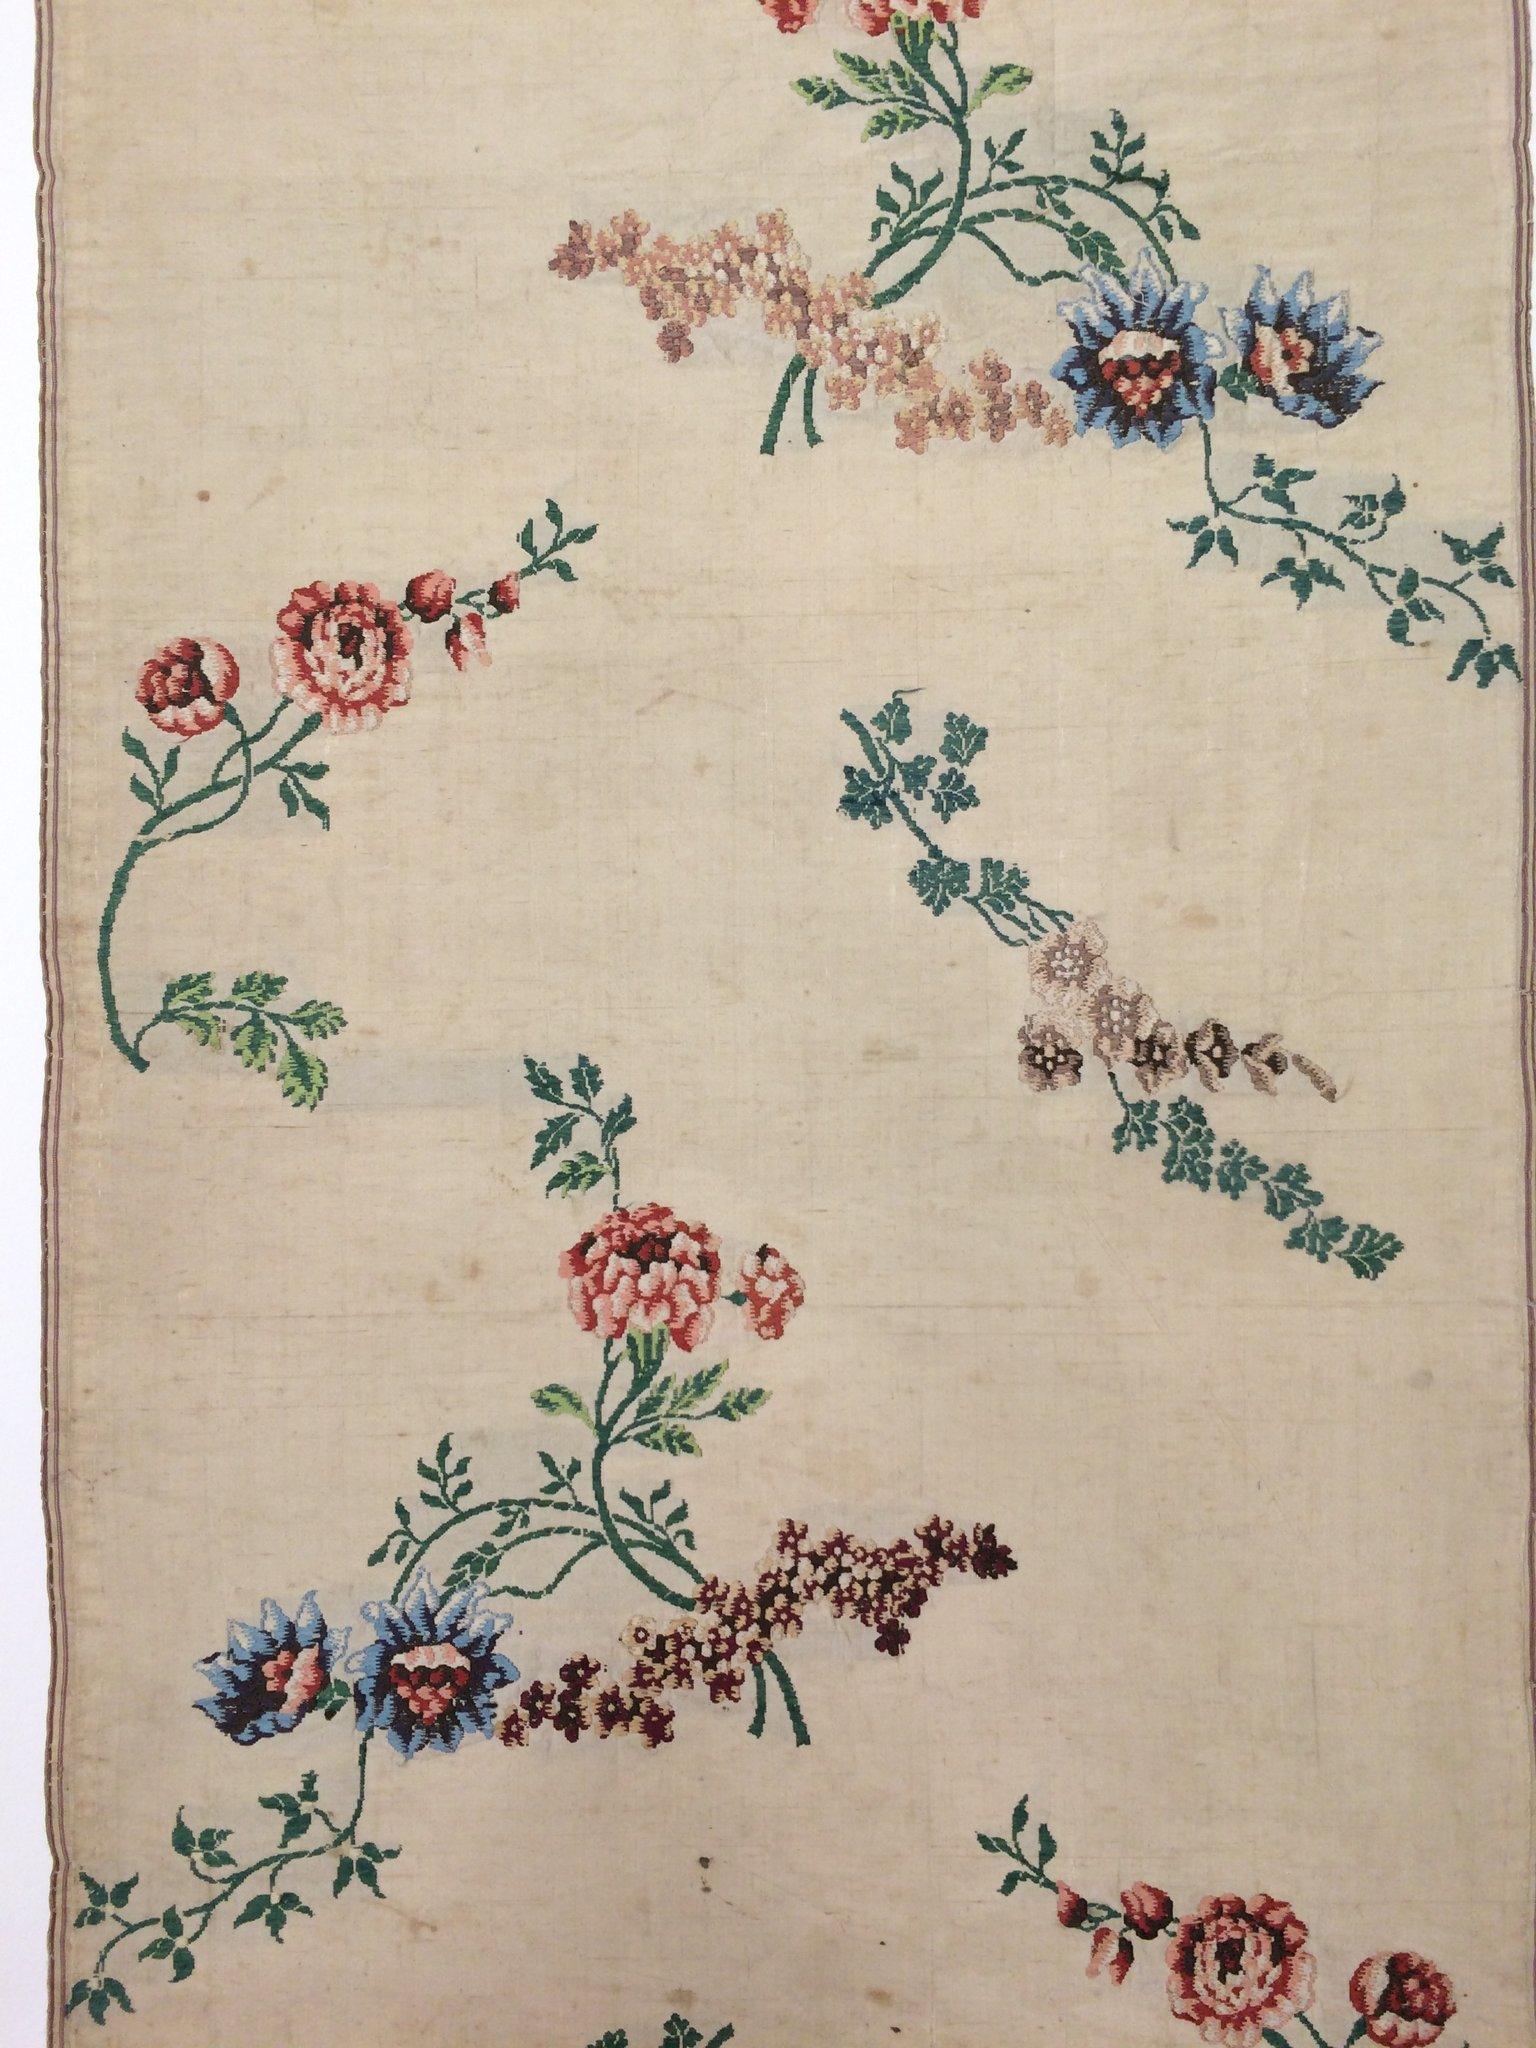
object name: skirt panel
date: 1750-1760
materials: silk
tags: flowers